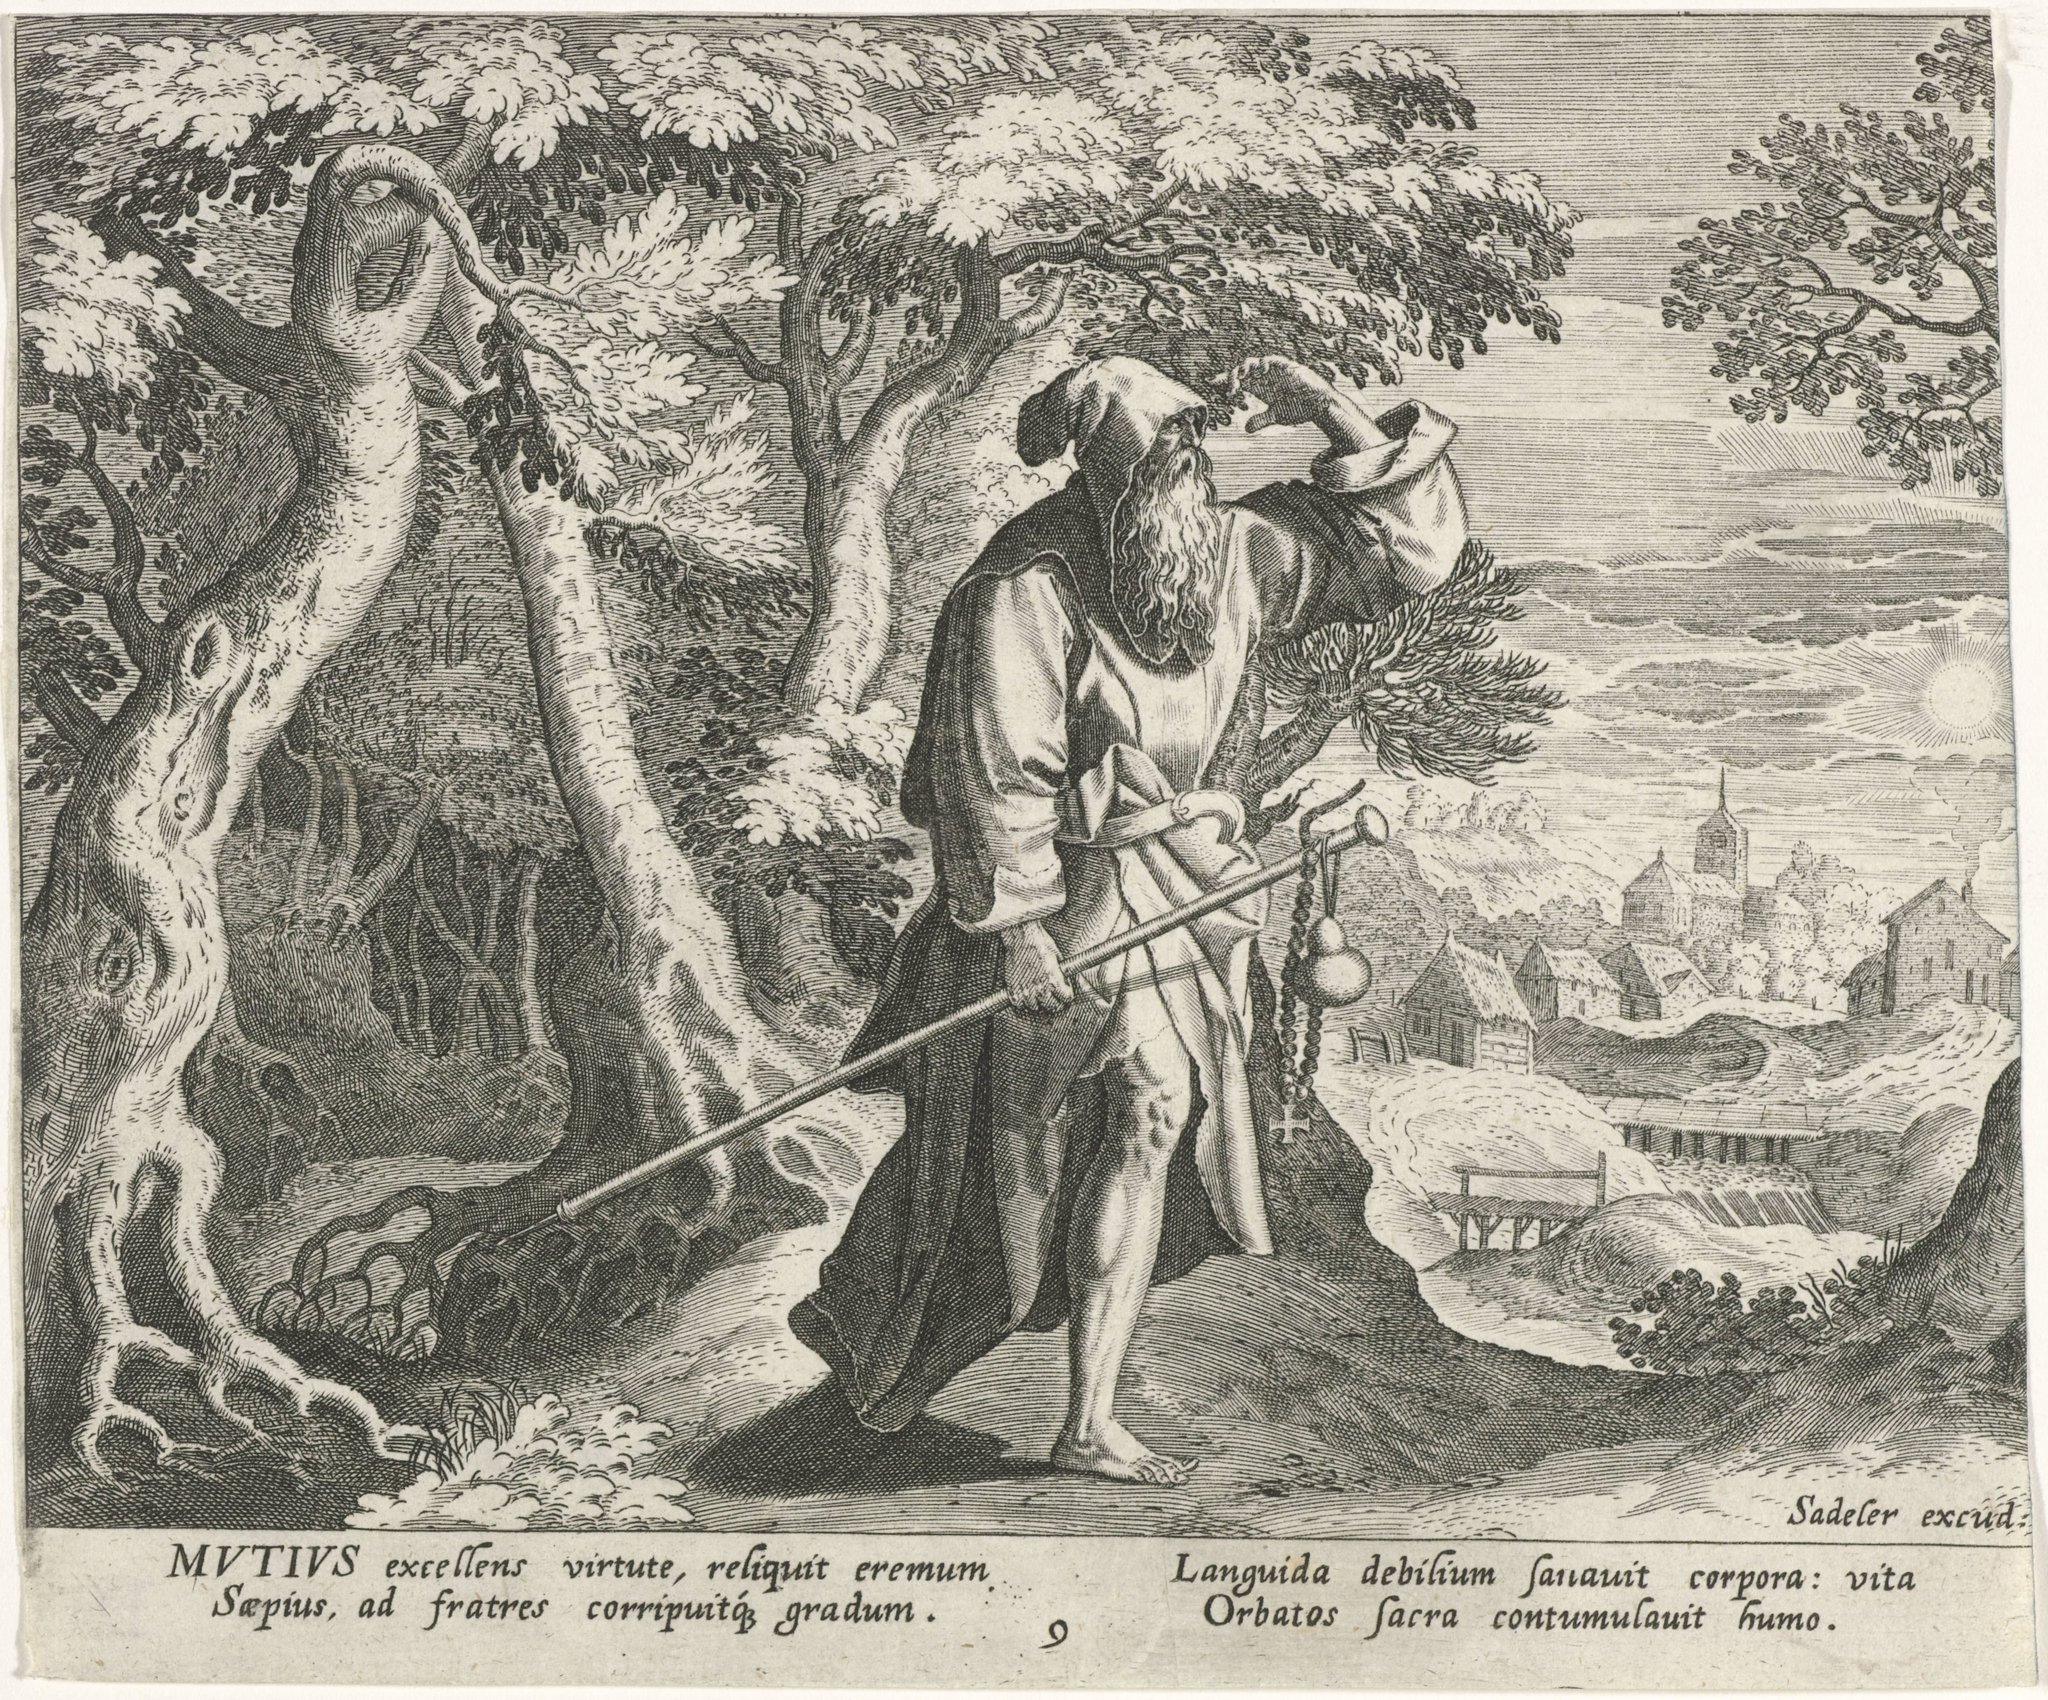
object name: print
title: Solitudo Sive Vitae Patrum Eremicolarum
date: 1583-1588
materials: paper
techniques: engraving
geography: antwerp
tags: saints, anchorite, hermit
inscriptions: collector's mark: Lugt 240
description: Mutius, een vroeg-christelijke kluizenaar, in een bos. In zijn handen een kluizenaarsstaf. Op de achtergrond een dorp met een beekje.